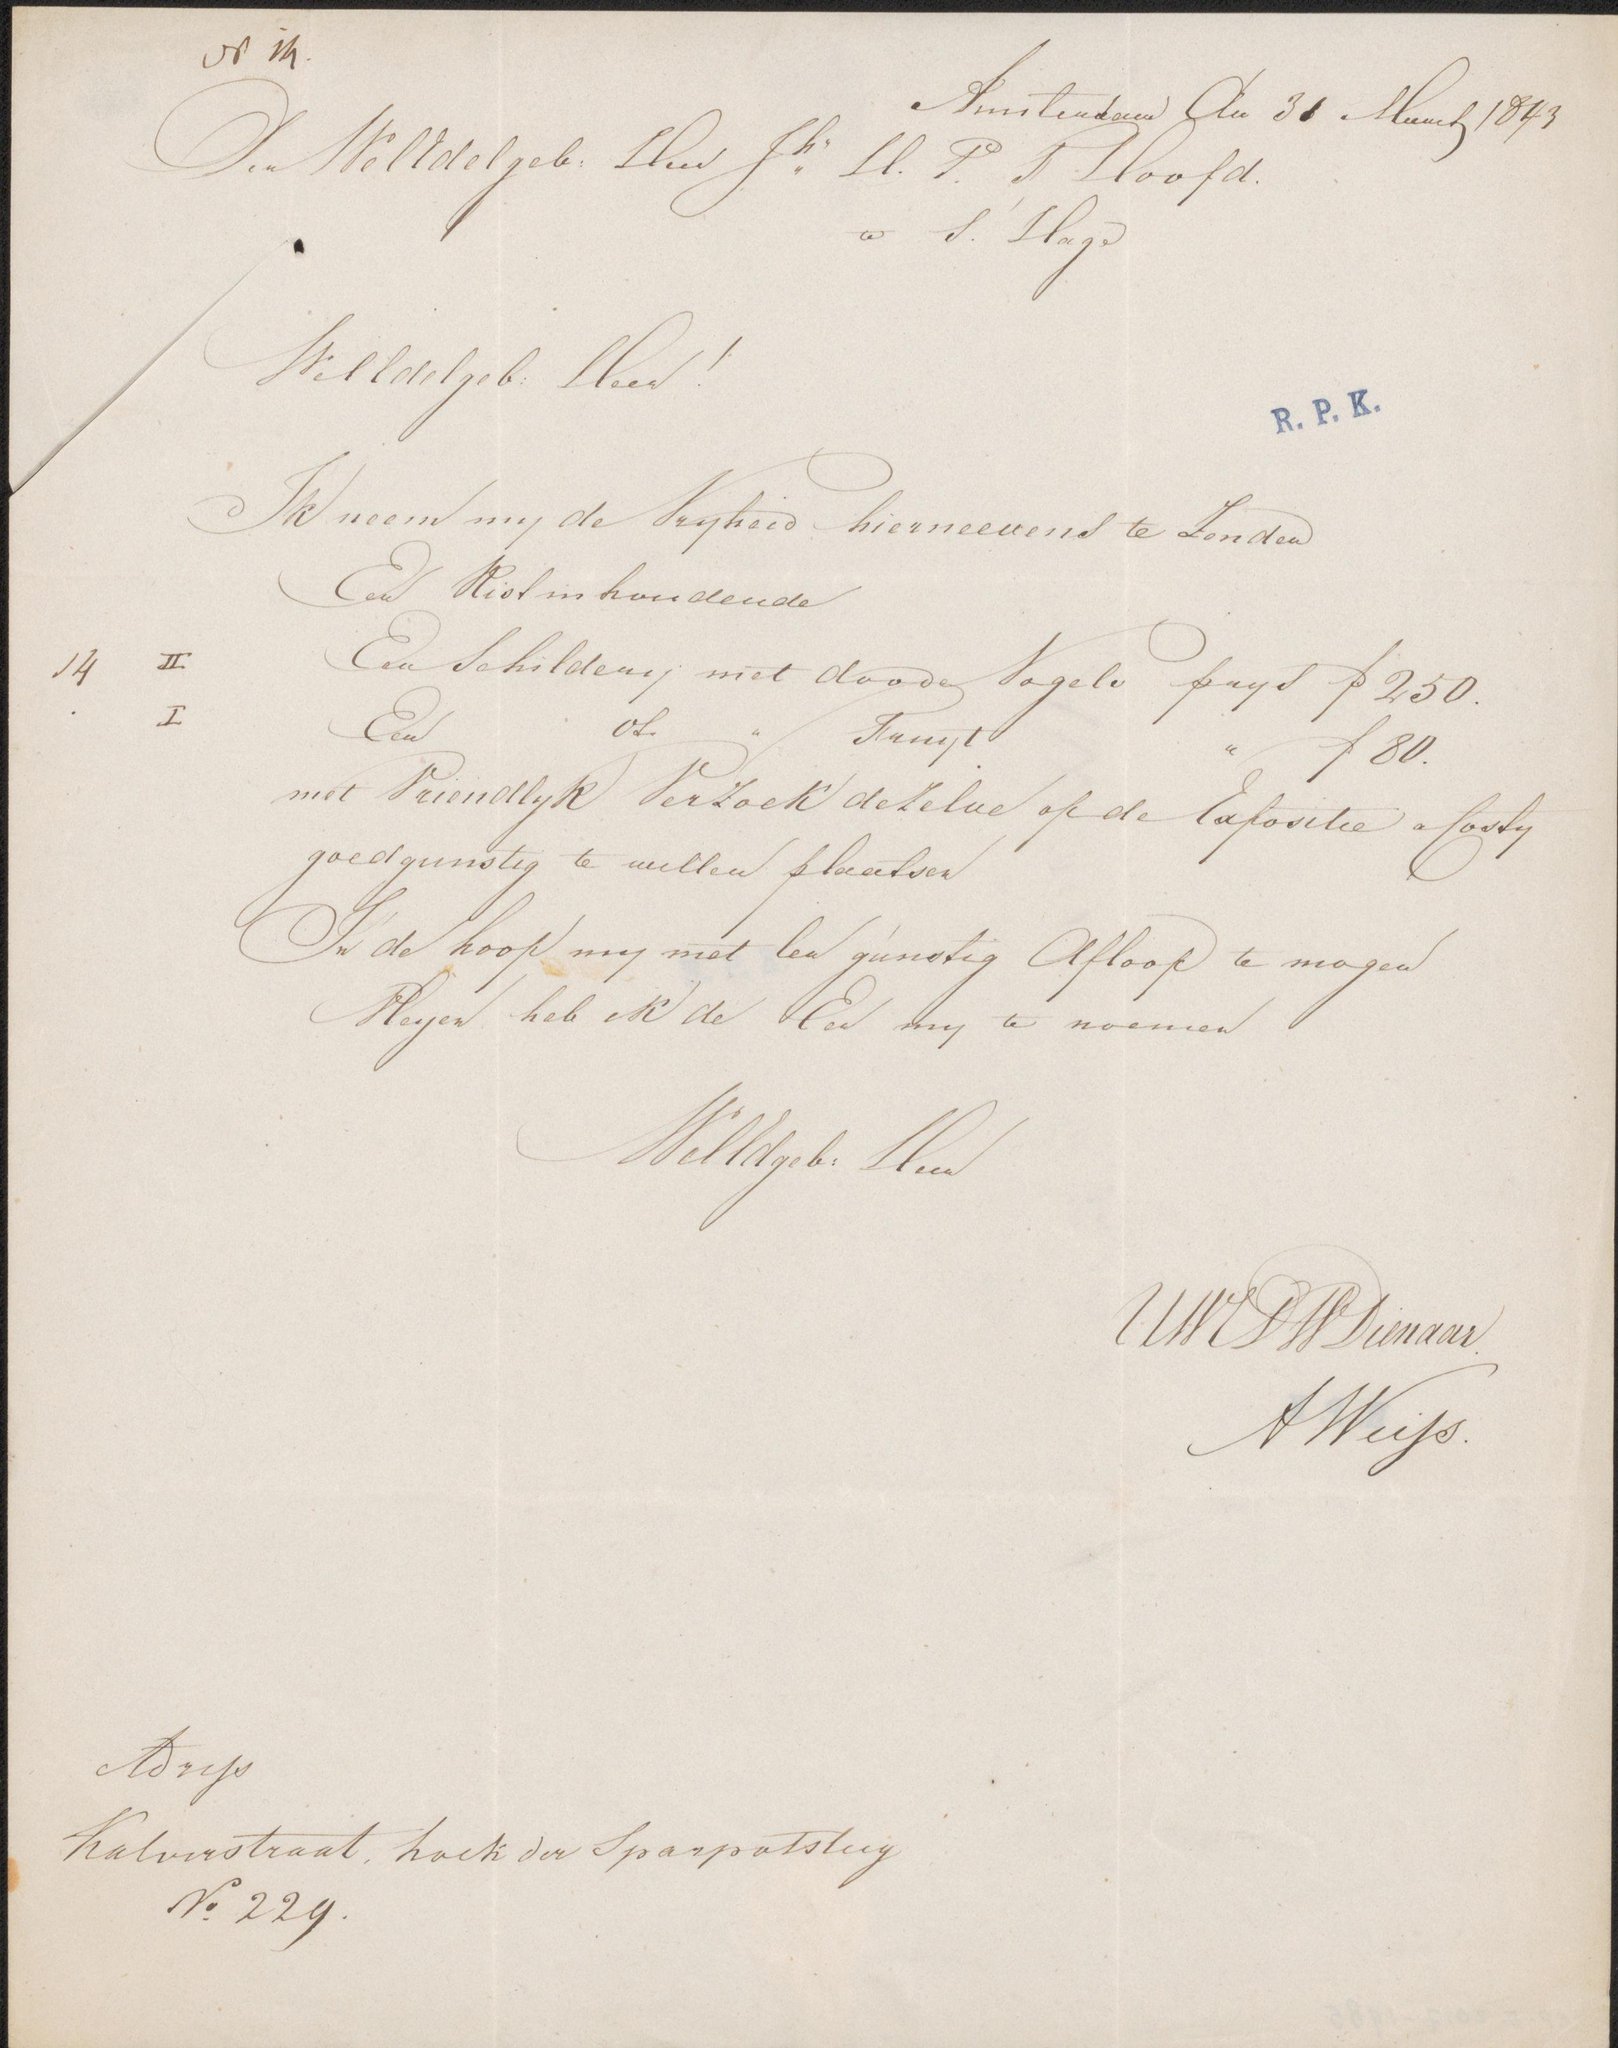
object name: letter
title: Brief aan jonkheer H.P.F. Hooft, secretaris van de commissie van de Tentoonstelling van Levende Meesters in Den Haag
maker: anton weiss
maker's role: draughtsman, print maker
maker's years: 1801-1851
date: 1843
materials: ink, paper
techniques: pen, writing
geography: haarlem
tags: painting (including book-illumination, miniature-painting), exhibition ~ art, money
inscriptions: collector's mark: Lugt 2233